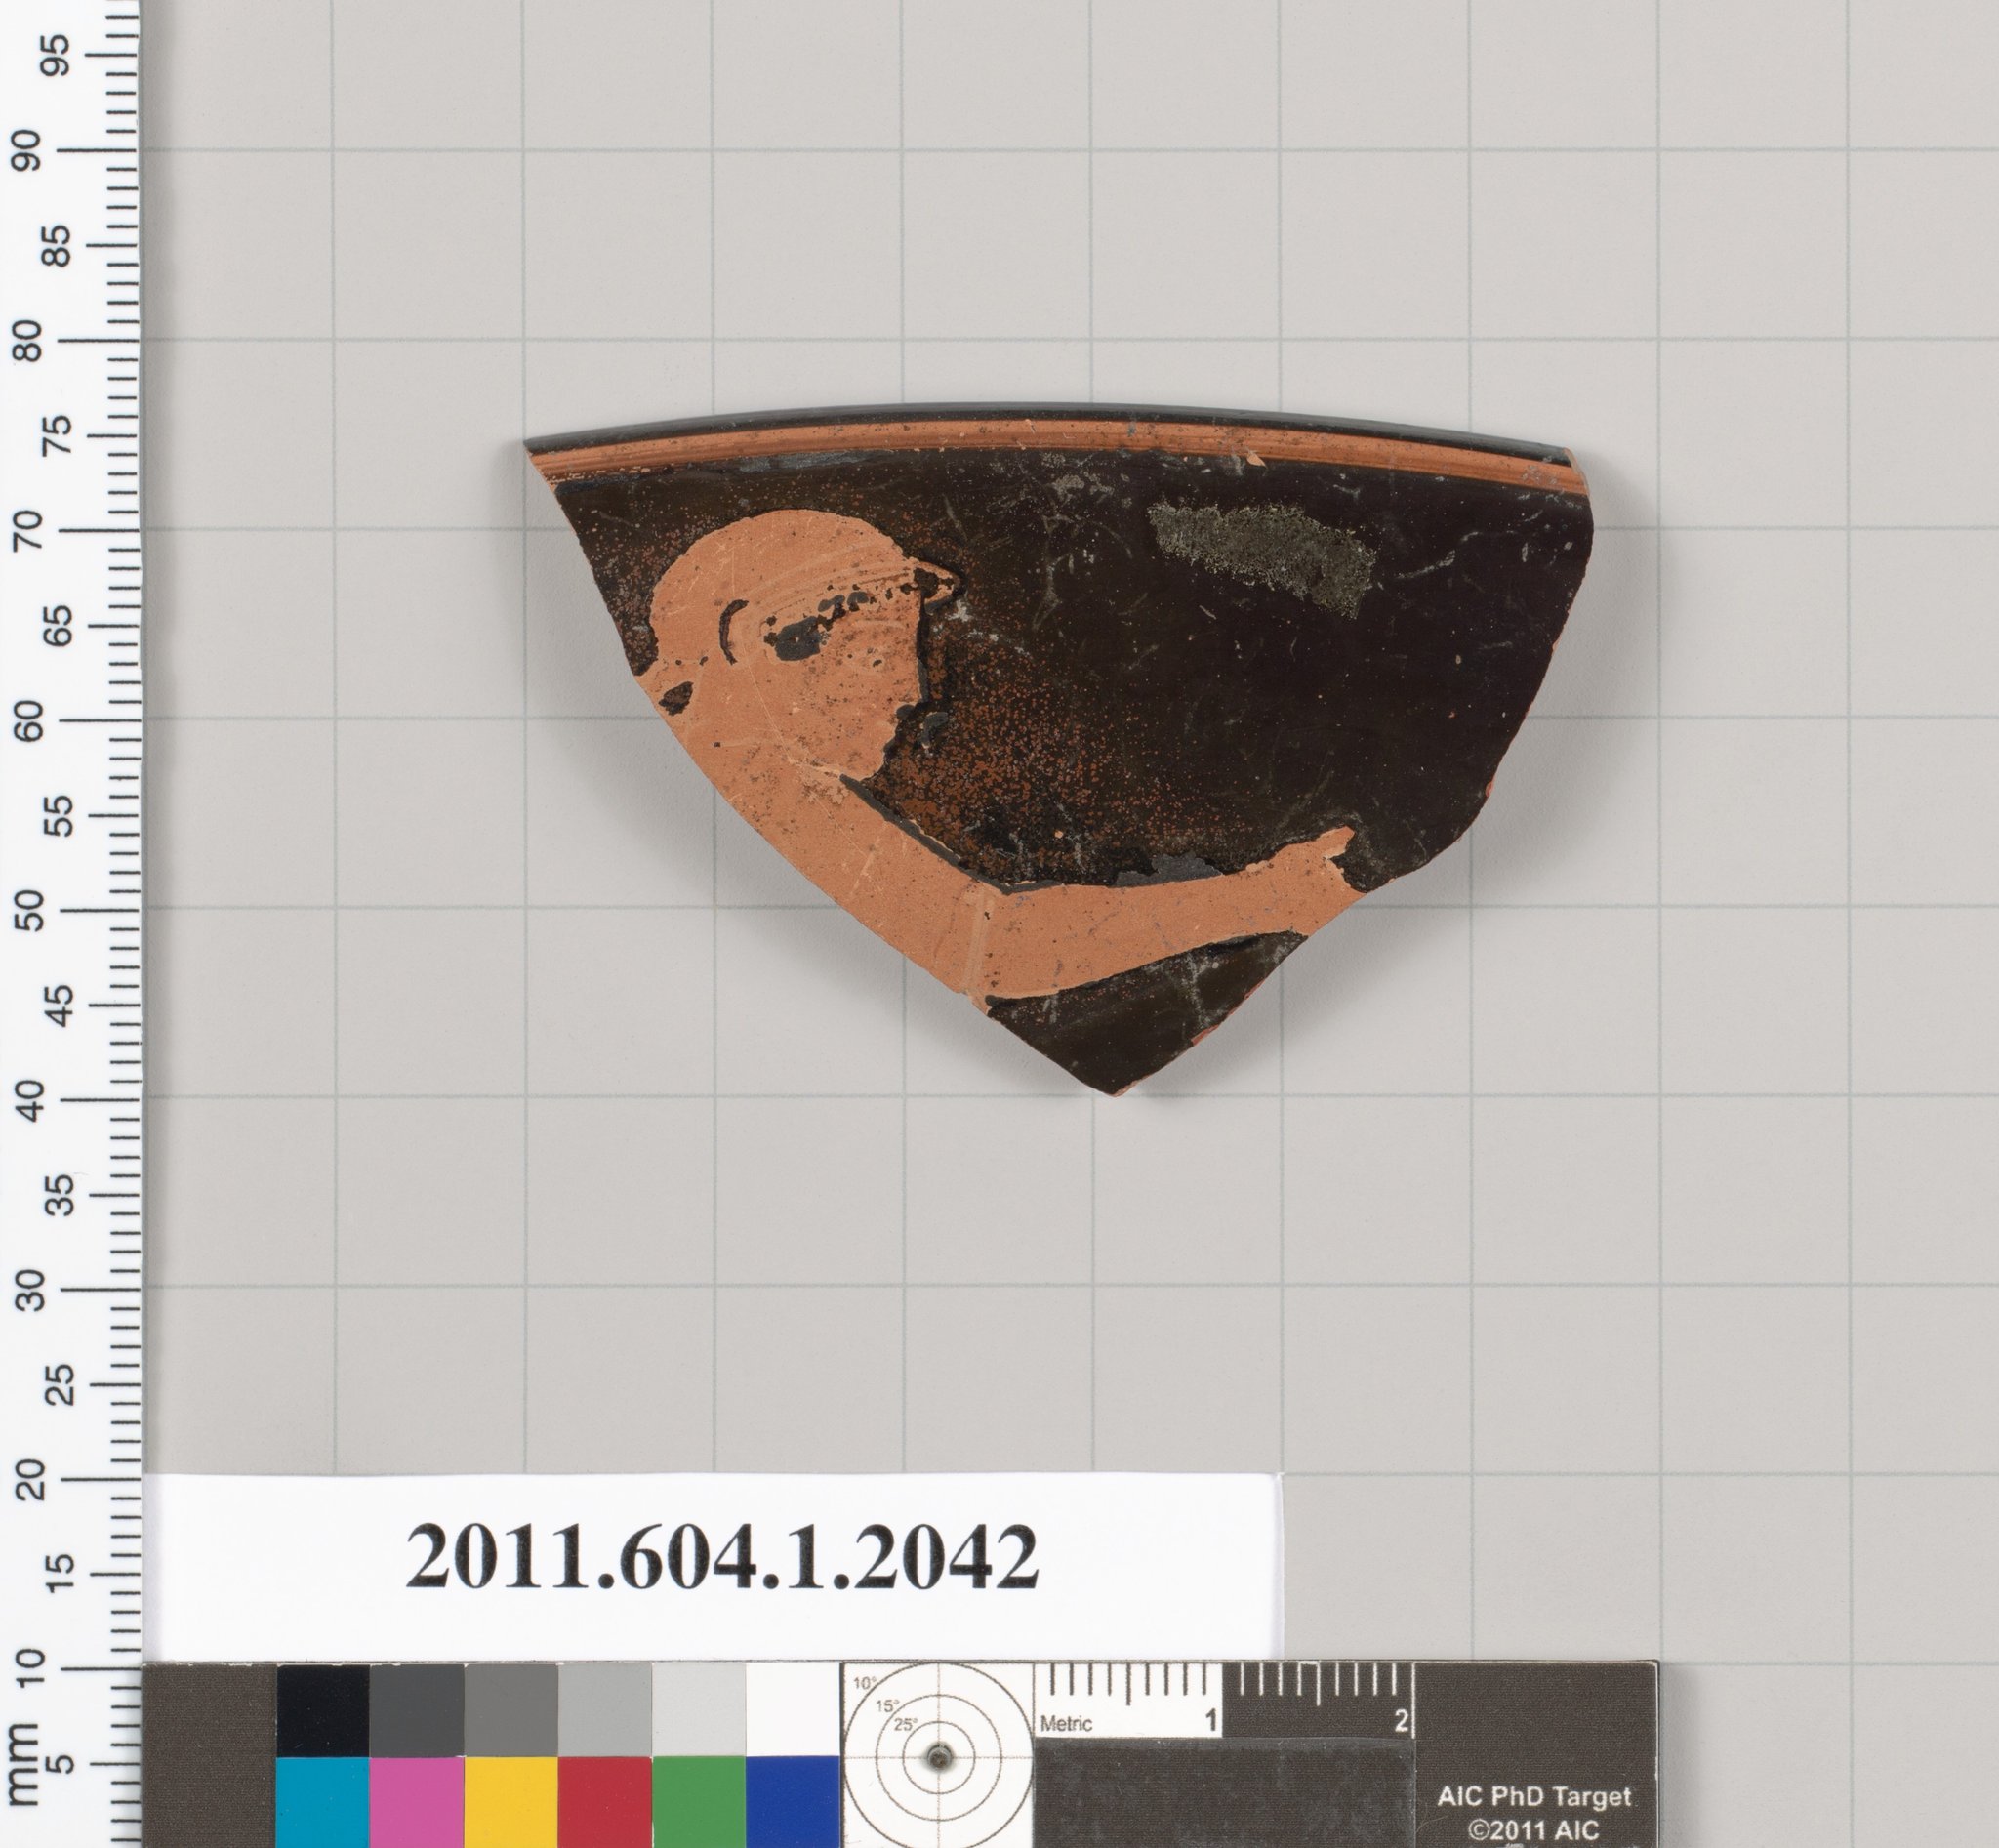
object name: kylix fragment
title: Terracotta rim fragment of a kylix (drinking cup)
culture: greek, attic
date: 475-451 BCE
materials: terracotta